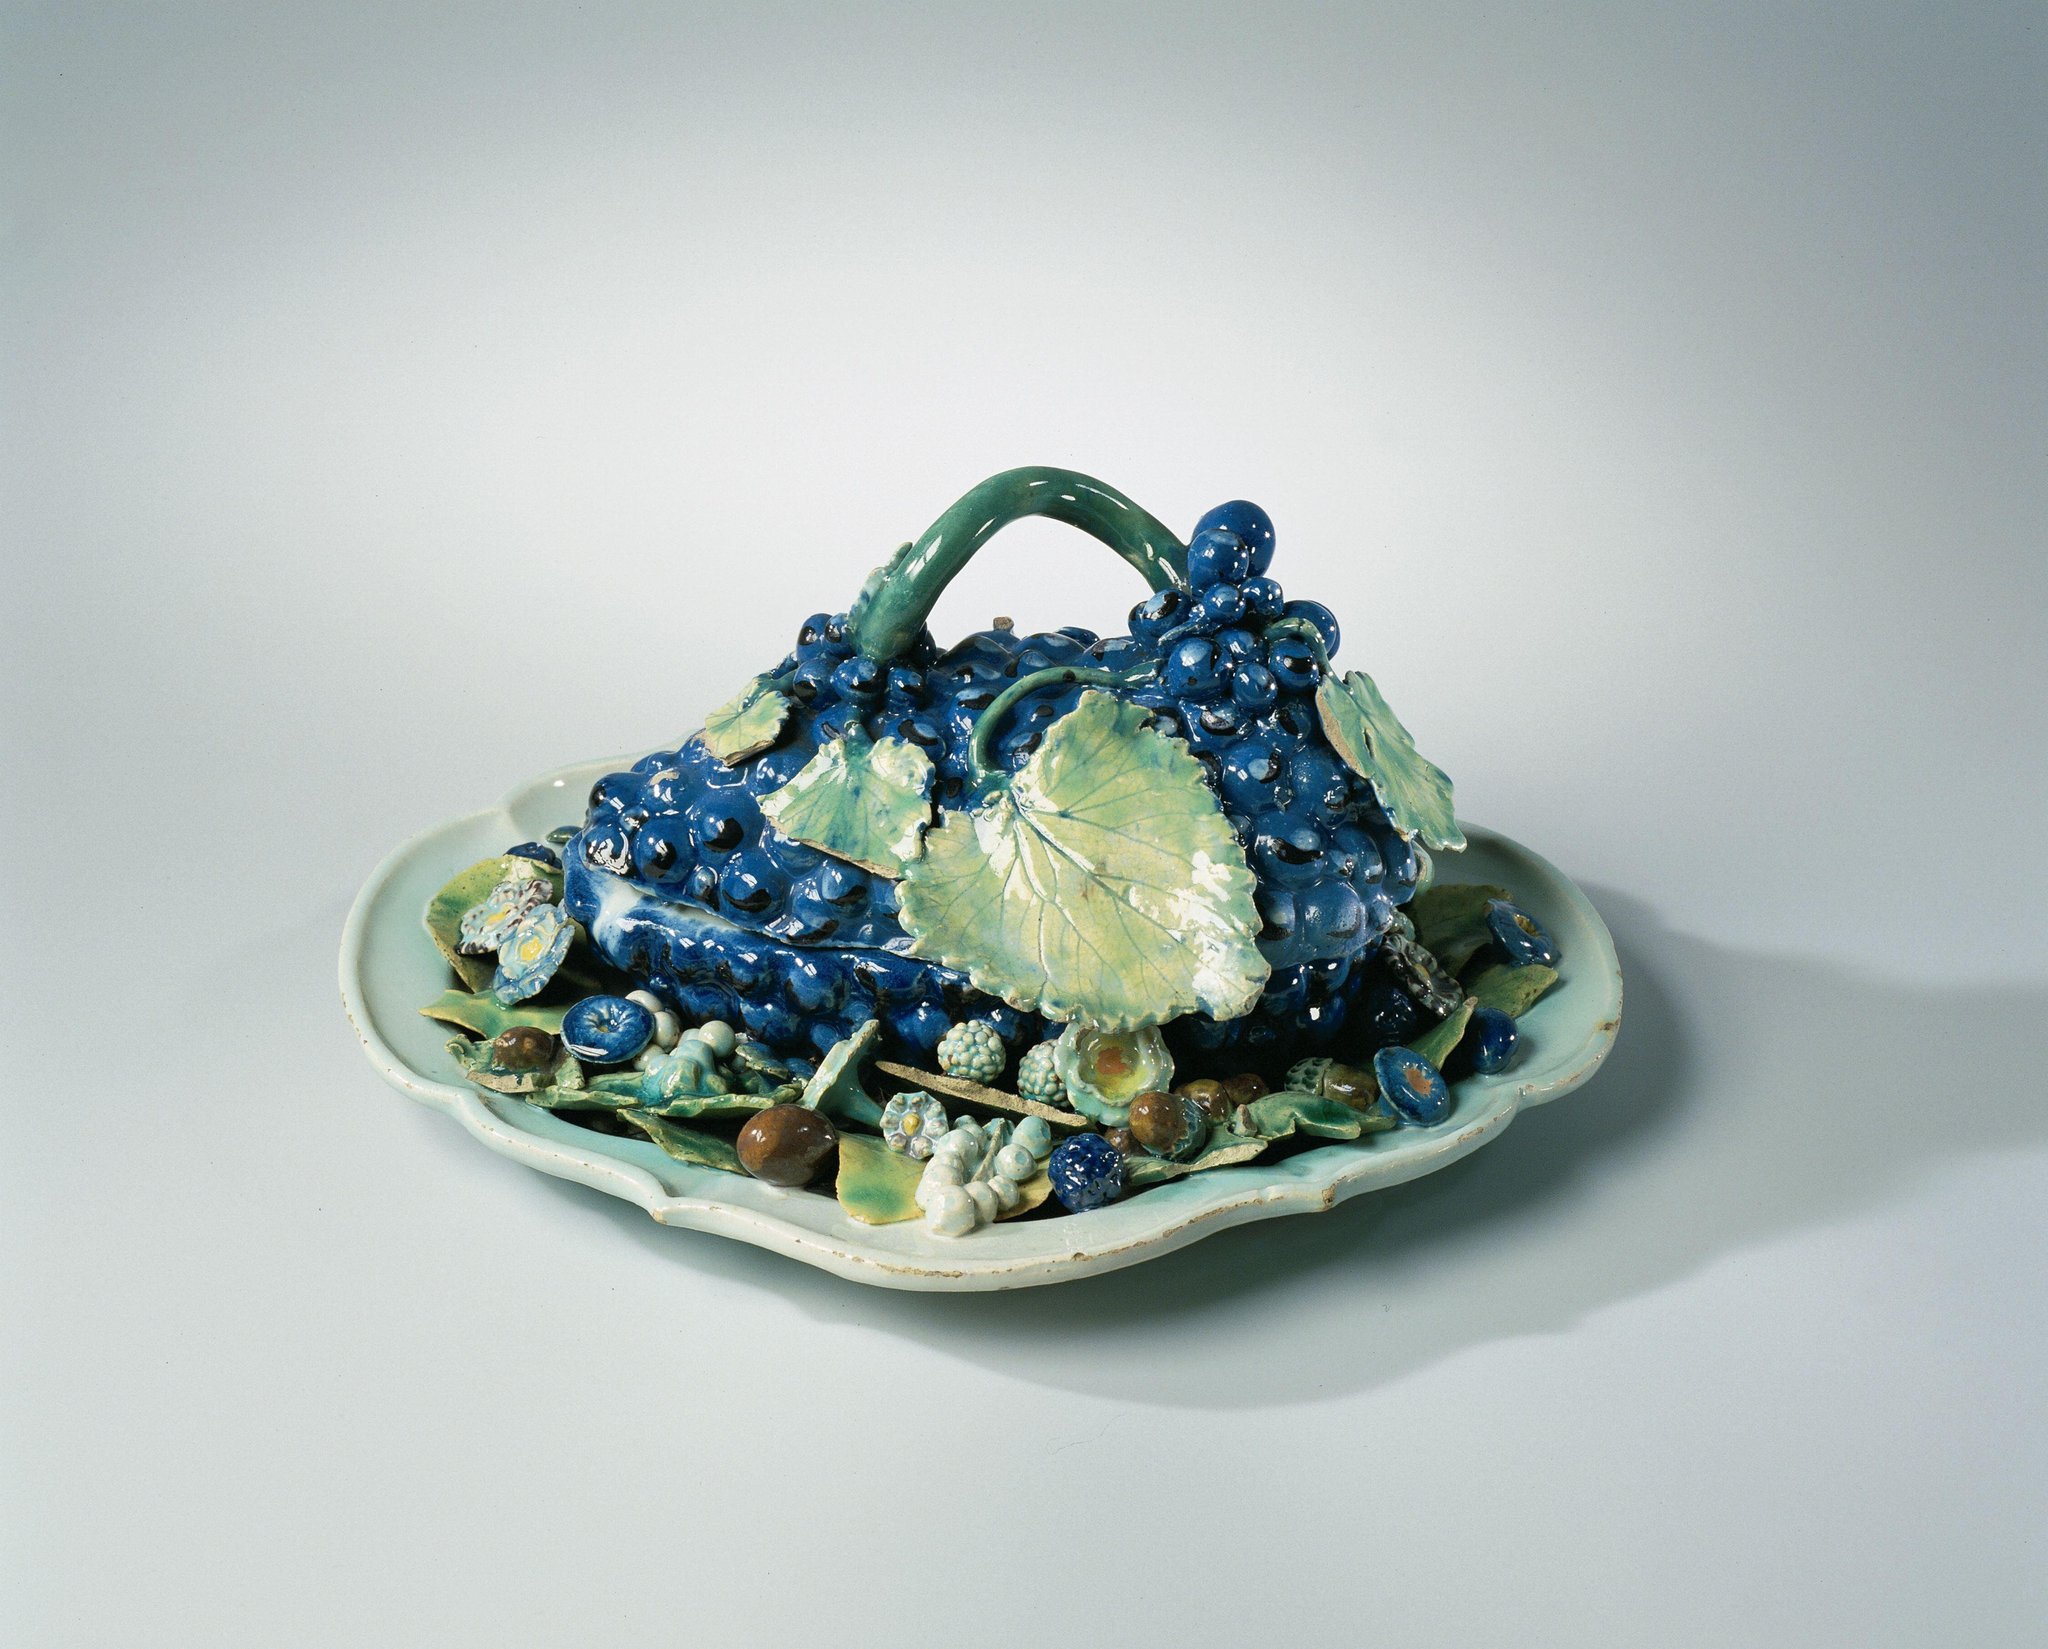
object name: butter dish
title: Botervloot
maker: arie blankers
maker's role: plateelbakker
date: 1756-1764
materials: earthenware, glaze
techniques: painted, polychromy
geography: amsterdam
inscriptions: mark: ‘A B’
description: Botervloot van veelkleurig beschilderde faience en staand op een bord. De vloot heeft de vorm van een blauwe druiventros en is op het bord bevestigd. Rond de tros zijn bloemen en bladeren op het bord bevesttigd. Het bord heeft een geschulpte rand. De botervloot is gemerkt.